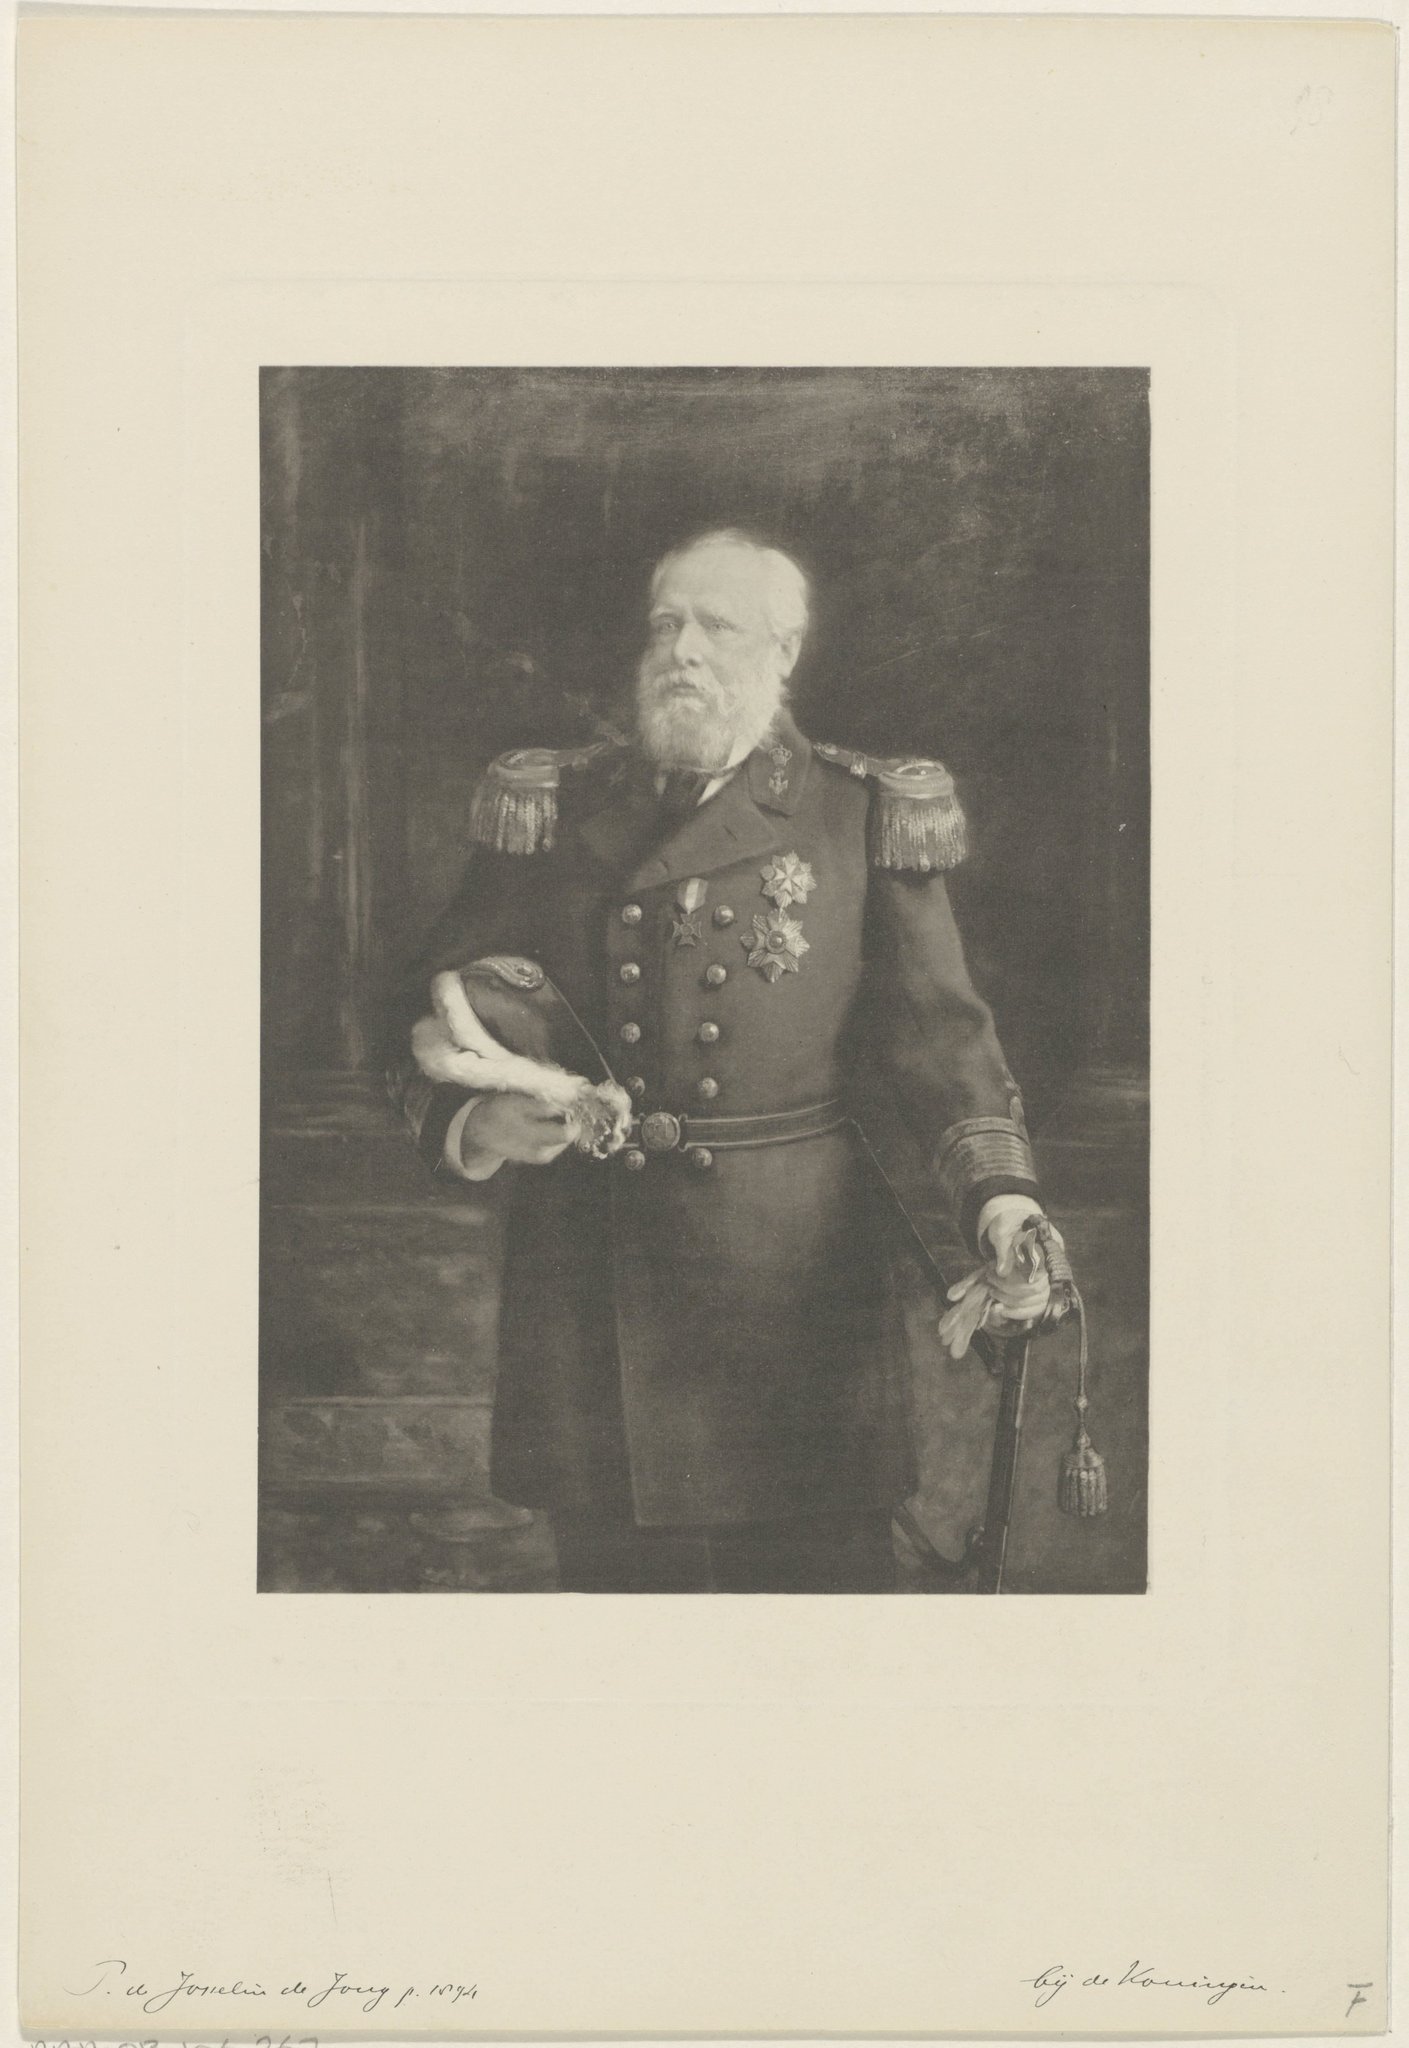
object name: photomechanical print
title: Portret van Willem III, koning der Nederlanden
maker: Anonymous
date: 1890-1949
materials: paper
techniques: photograph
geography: netherlands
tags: willem iii (koning der nederlanden)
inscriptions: collector's mark: Lugt 2228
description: De hier vermelde titel verwijst naar de hoogst verkregen titel van de geportretteerde, niet per se naar de titel die de geportretteerde op deze voorstelling draagt.